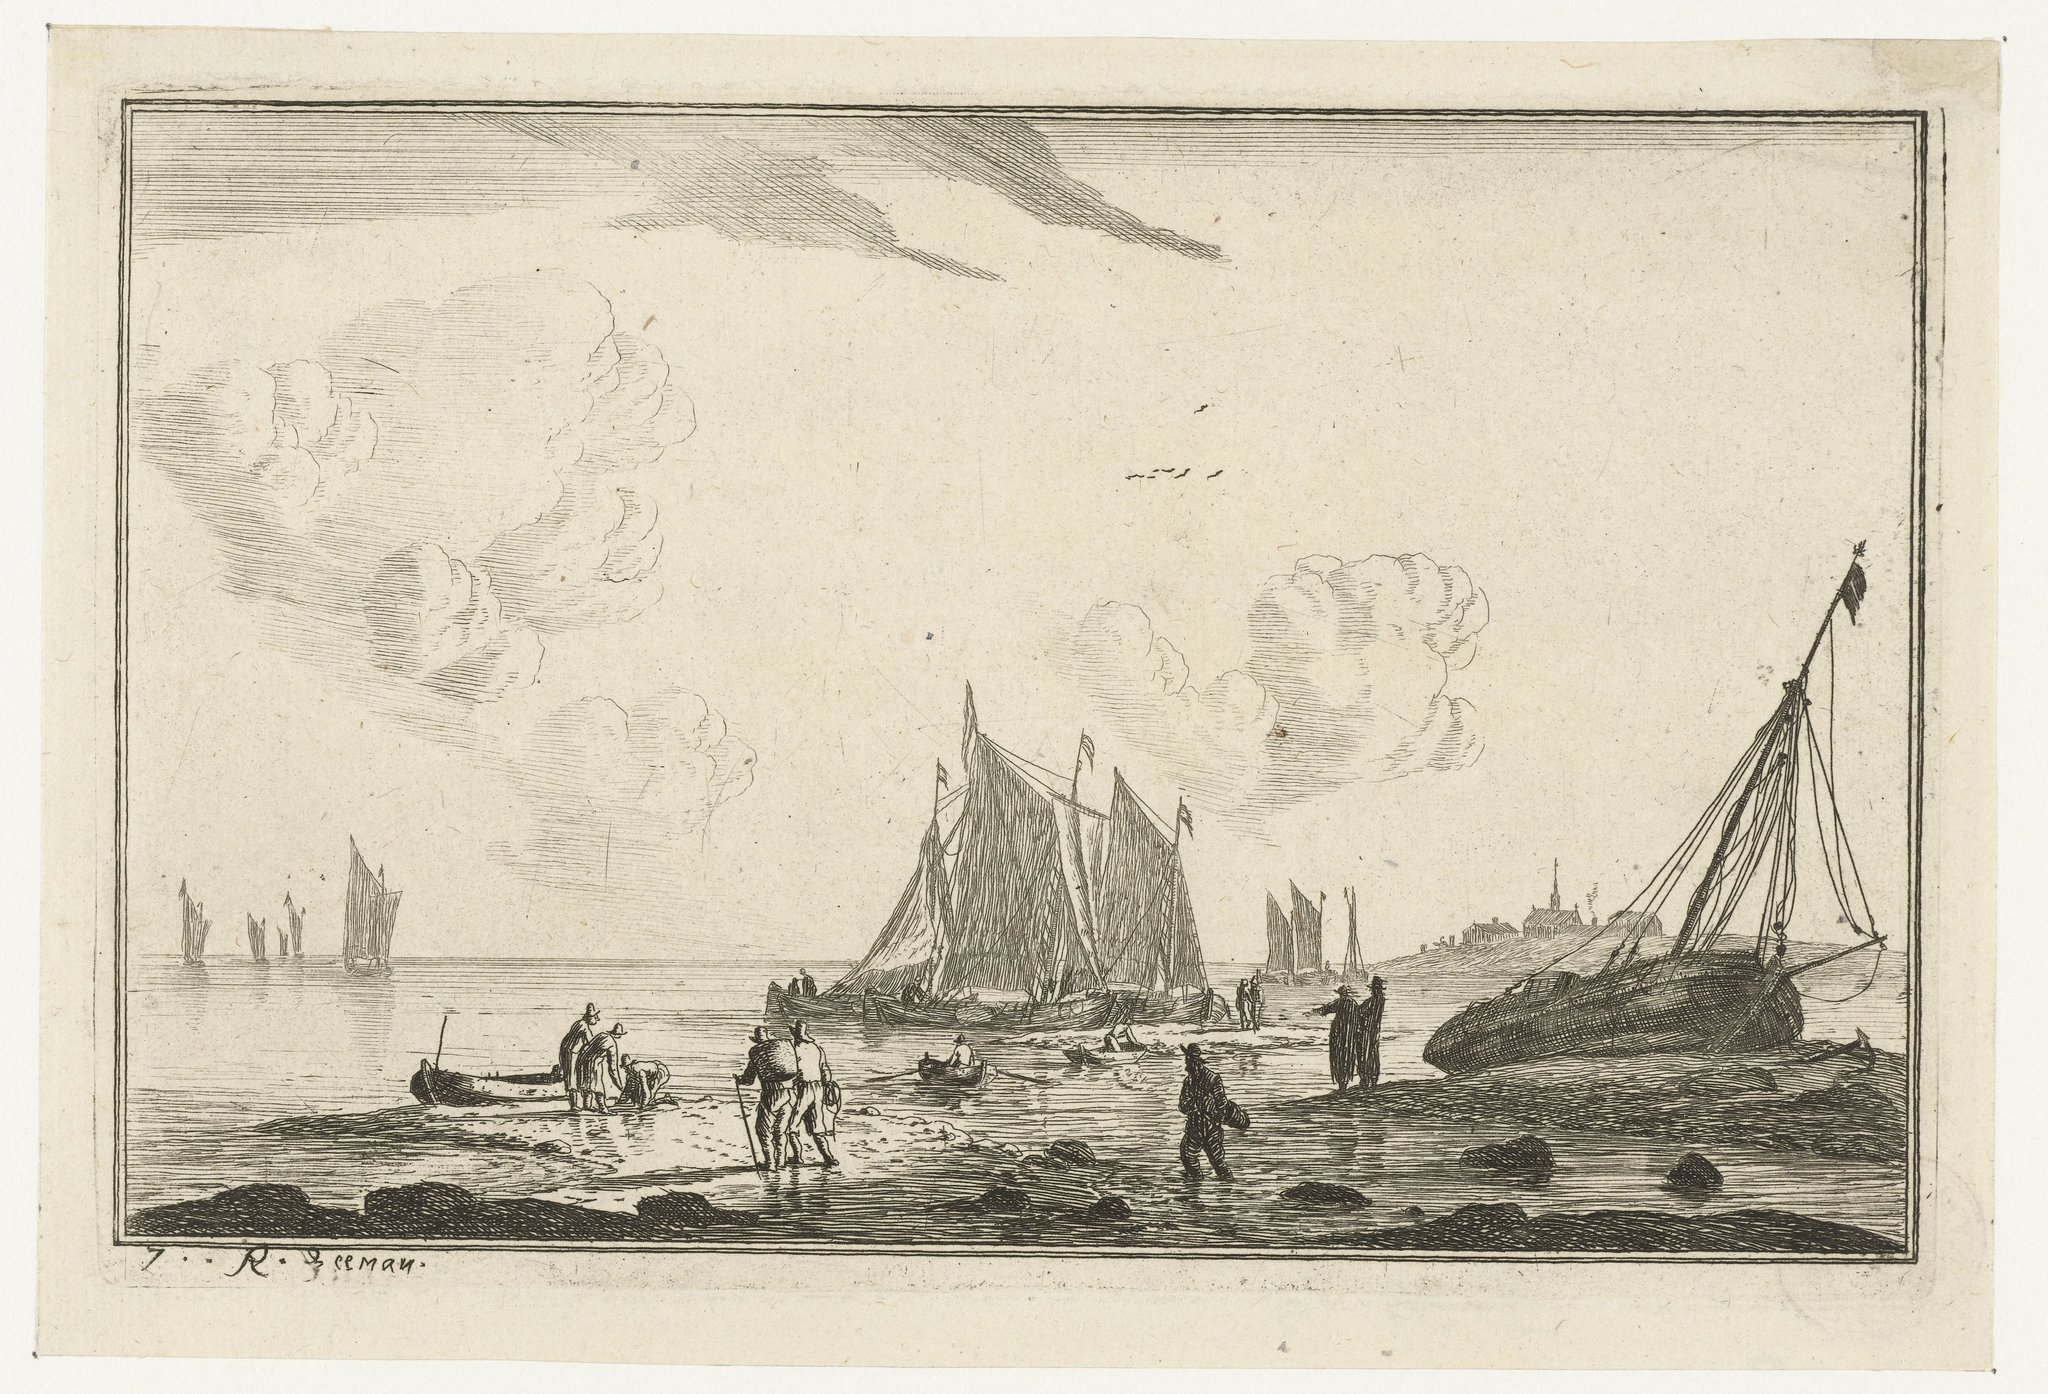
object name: print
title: Strand met een op het zand getrokken zeilschip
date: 1654-1748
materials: paper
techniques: etching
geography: netherlands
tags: sailing-ship, sailing-boat, beach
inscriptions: collector's mark: Lugt 12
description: Mensen lopend op het strand en door het ondiepe water. Een zeilschip op het zand getrokken, een aantal boten liggend in het ondiepe water en een aantal varend op het open water. Op een hoger gelegen stuk land een klein dorp. Dubbele rand rondom voorstelling.